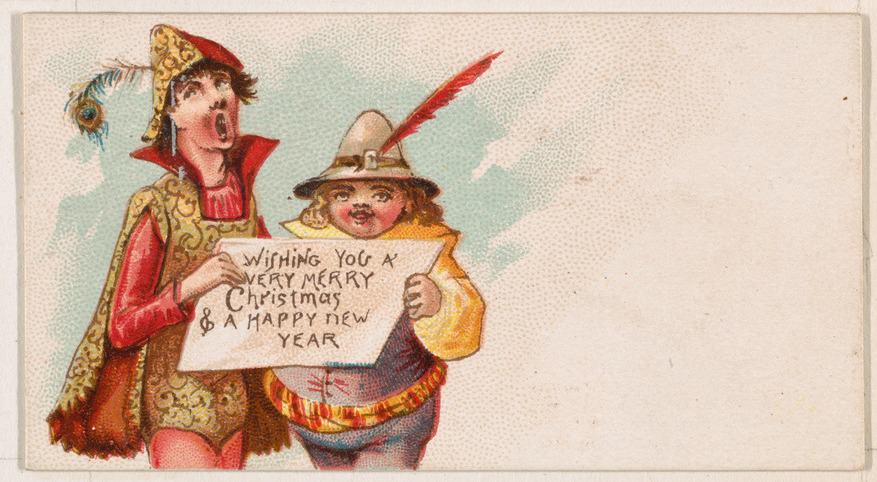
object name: print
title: Wishing You a Very Merry Christmas and a Happy New Year, from the New Years 1890 series (N227) issued by Kinney Bros.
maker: kinney brothers tobacco company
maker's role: publisher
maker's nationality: american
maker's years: 1869-2011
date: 1889-1890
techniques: color lithograph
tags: men,women,christmas